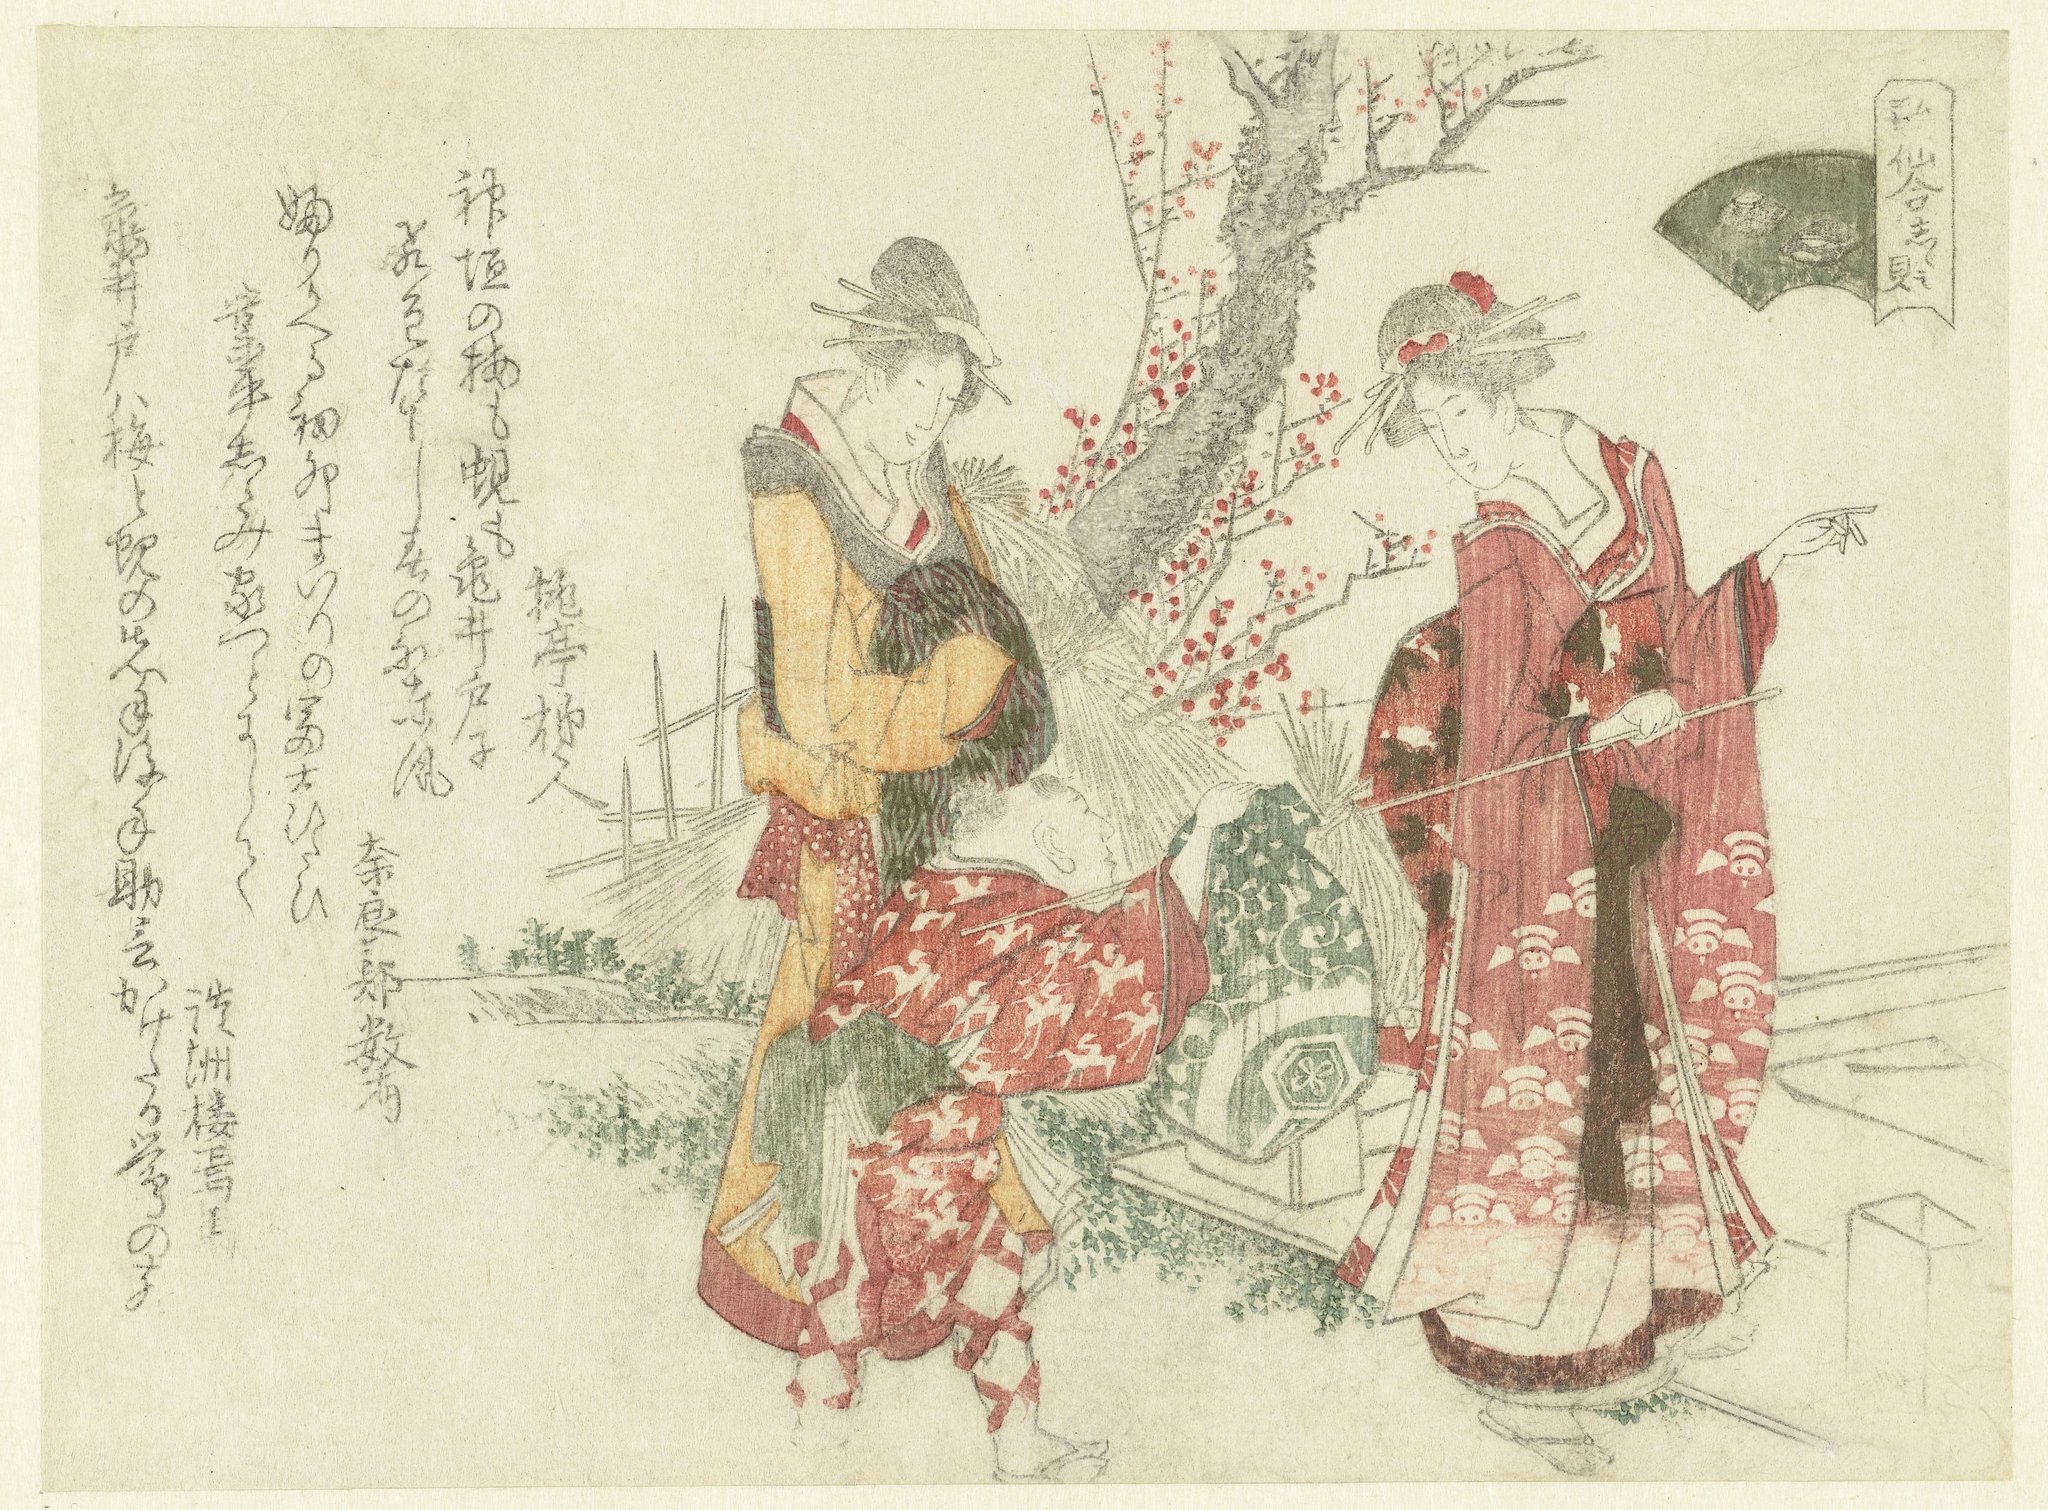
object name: print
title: Fresh-water clam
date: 1809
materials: paper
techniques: woodcut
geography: japan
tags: boy (child between toddler and youth), adult woman (+ two persons), landscapes (+ landscape with figures, staffage)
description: Een surimono is een luxe uitgevoerde prent waarop beeld met één of meerdere gedichten gecombineerd is. Bij het drukken van een surimono werd vaak gebruik gemaakt van dikker papier, blinddruk en metaal pigmenten, zoals koper- en zilverpoeder. De prenten werden vaak in opdracht van dichters gemaakt en als exclusief geschenk aan vrienden en relaties gegeven.